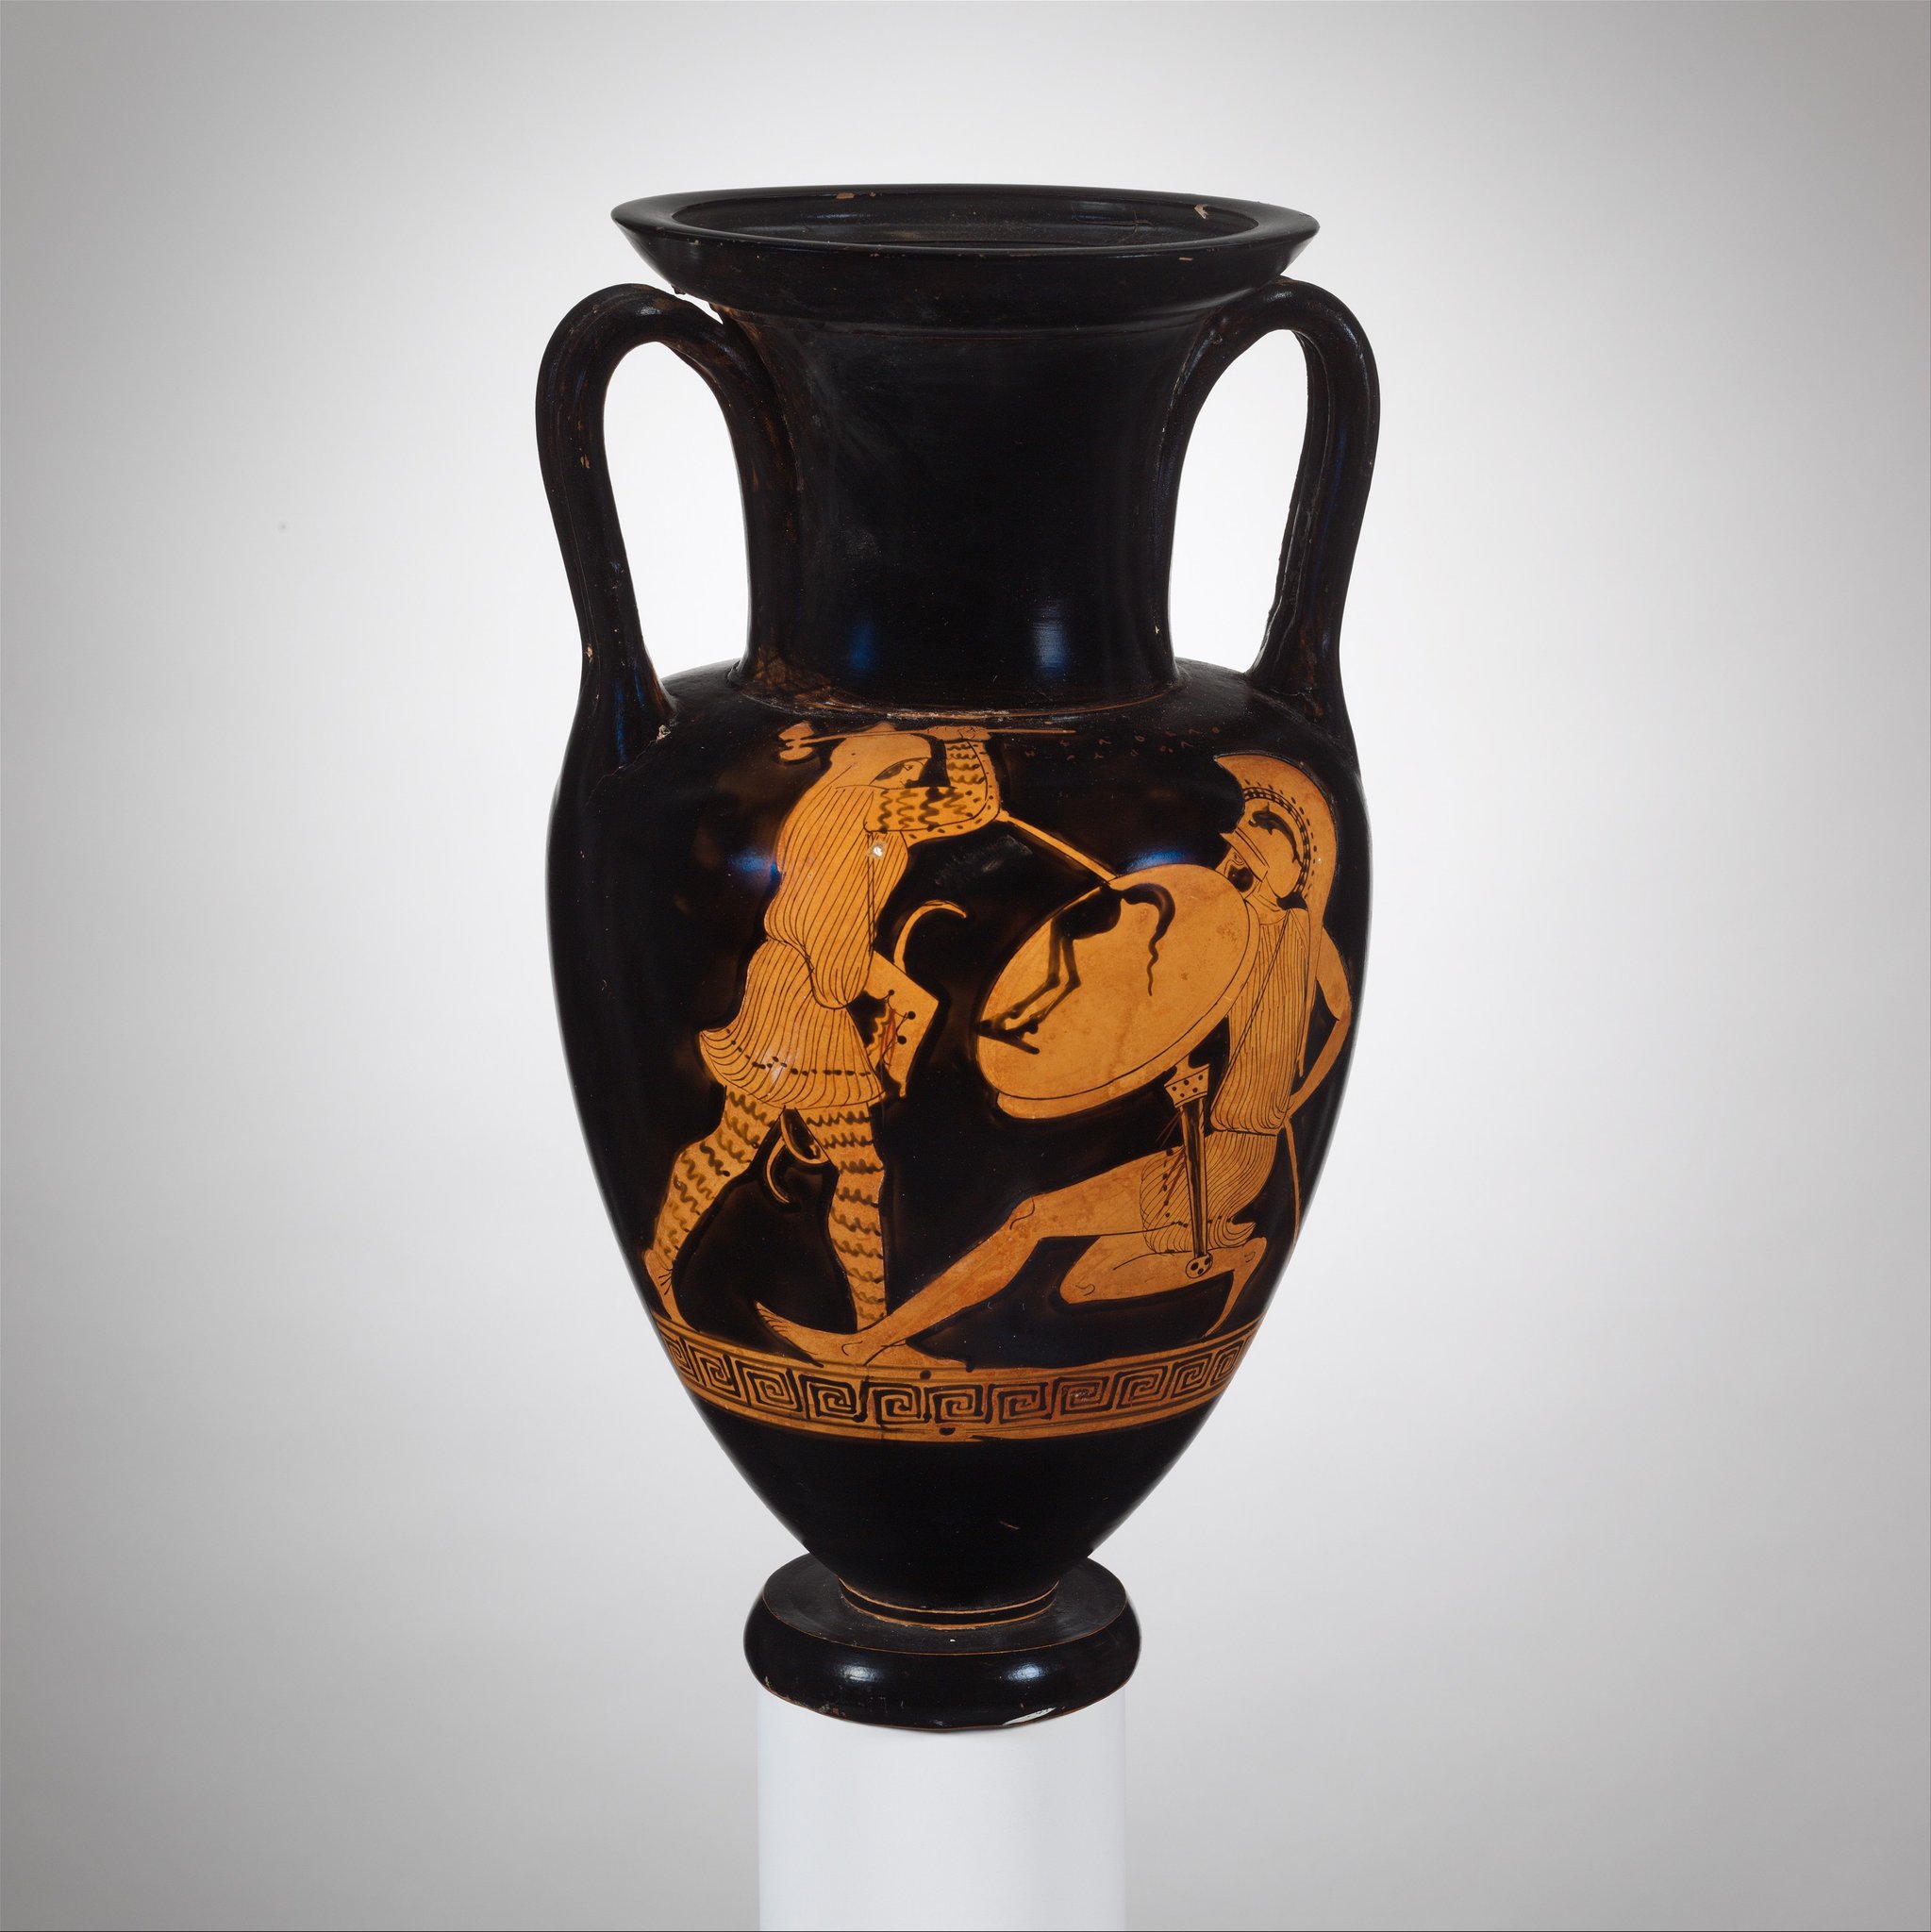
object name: nolan neck amphora with triple handle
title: Terracotta Nolan neck-amphora (jar)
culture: greek, attic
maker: alkimachos painter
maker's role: artist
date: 470-460 BCE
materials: terracotta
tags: soldiers,shields,men,amazons